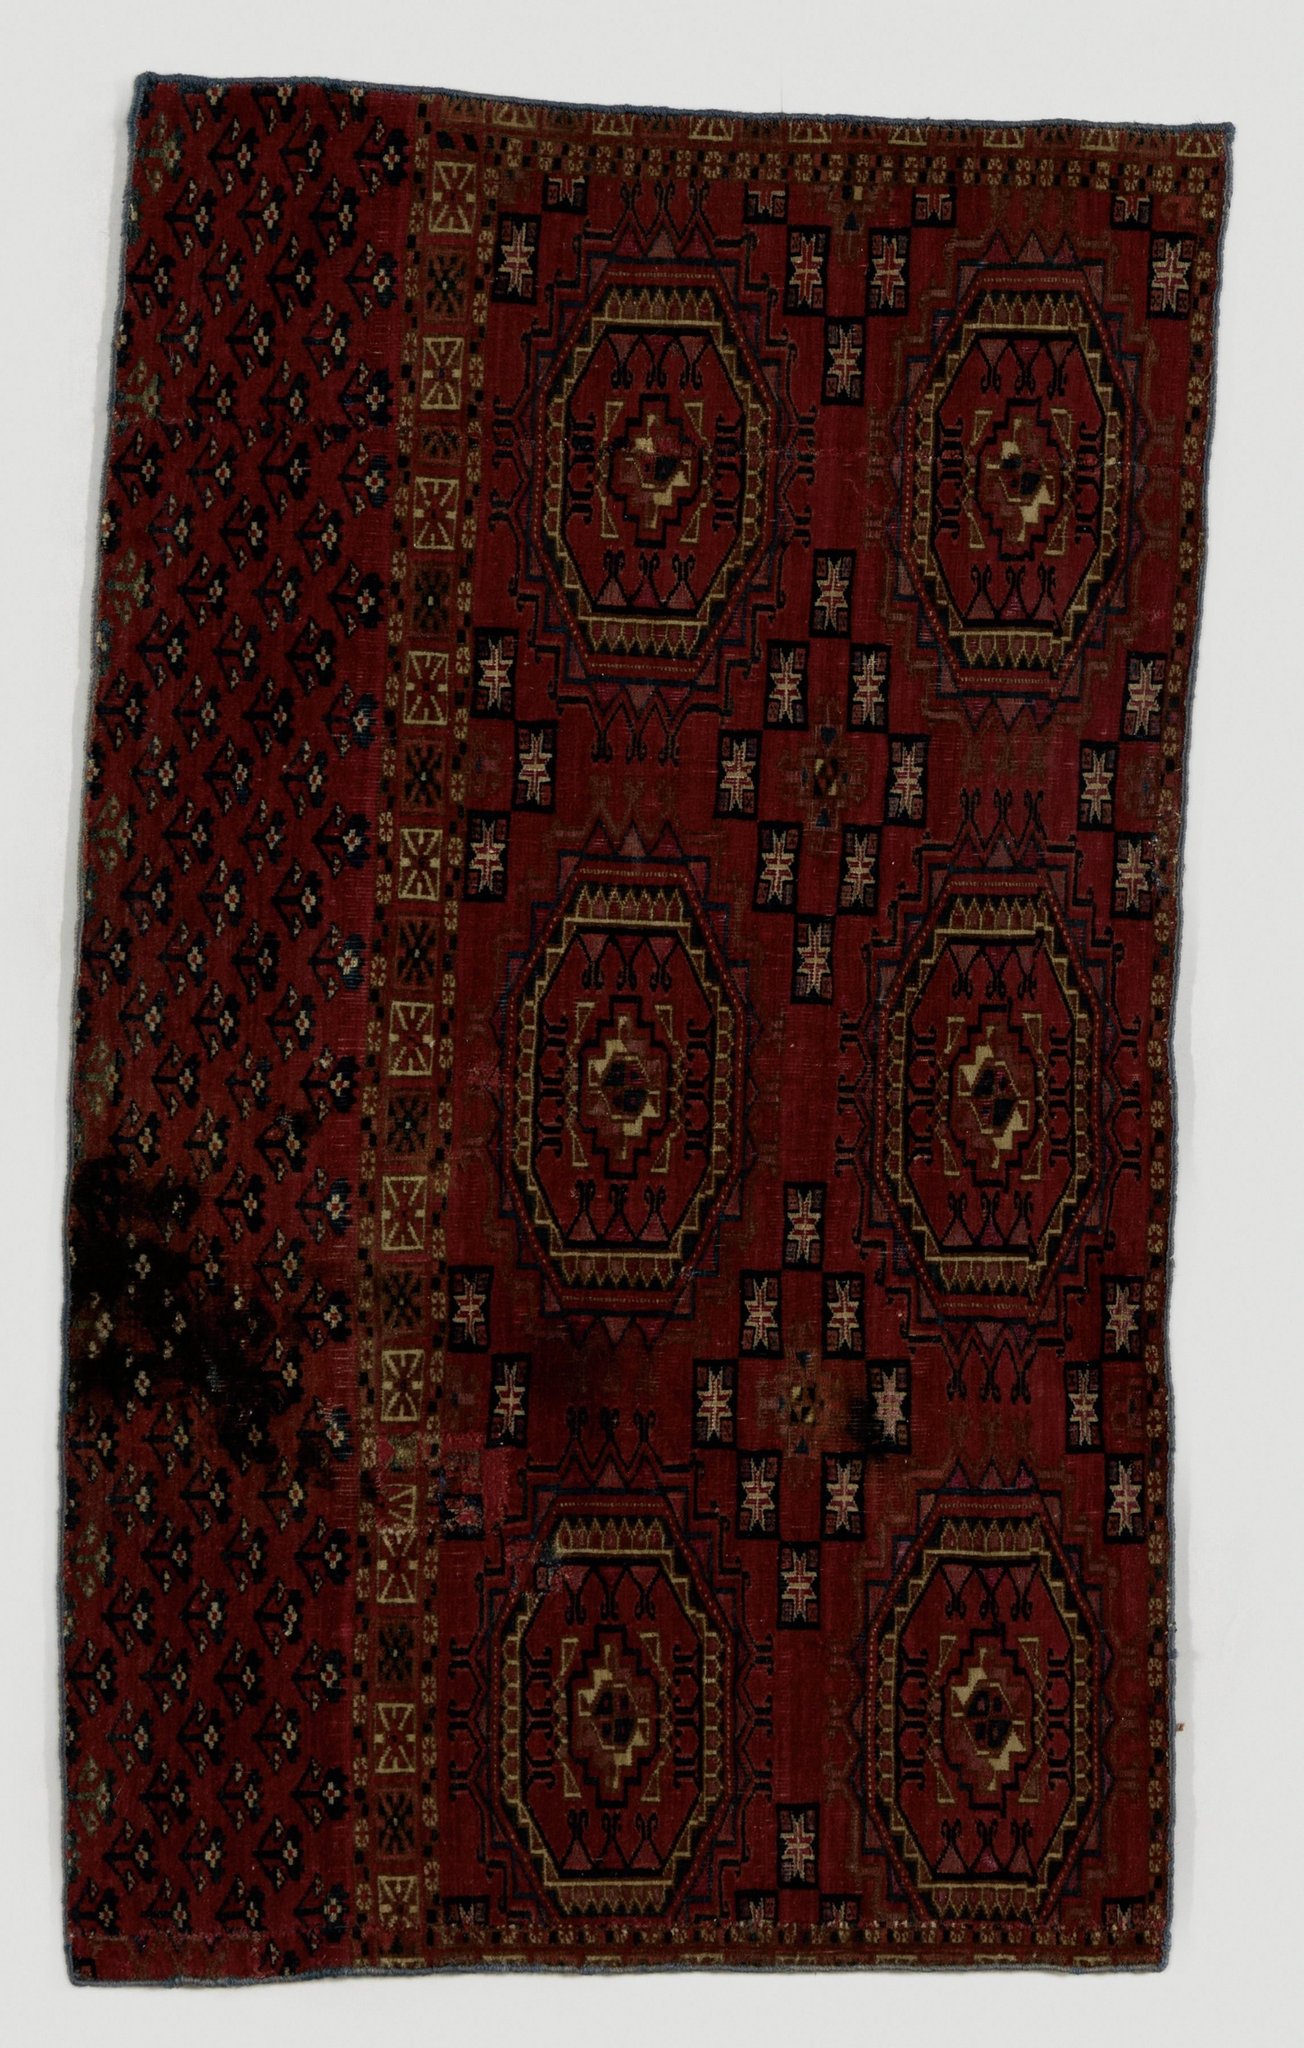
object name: tentzakvoorblad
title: Groot model tentzakvoorblad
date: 1850-1890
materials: cotton, silk, wool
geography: south turkestan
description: Tentzakvoorblad in groot model, Tekke Chuval. In het middenveld staan drie banen van twee guls tegen een bordeauxrode achtergrond. De rand is alleen aan de bovenzijde aanwezig en versierd met geometrische rechthoekige ornamenten, de elem is versierd met planten.